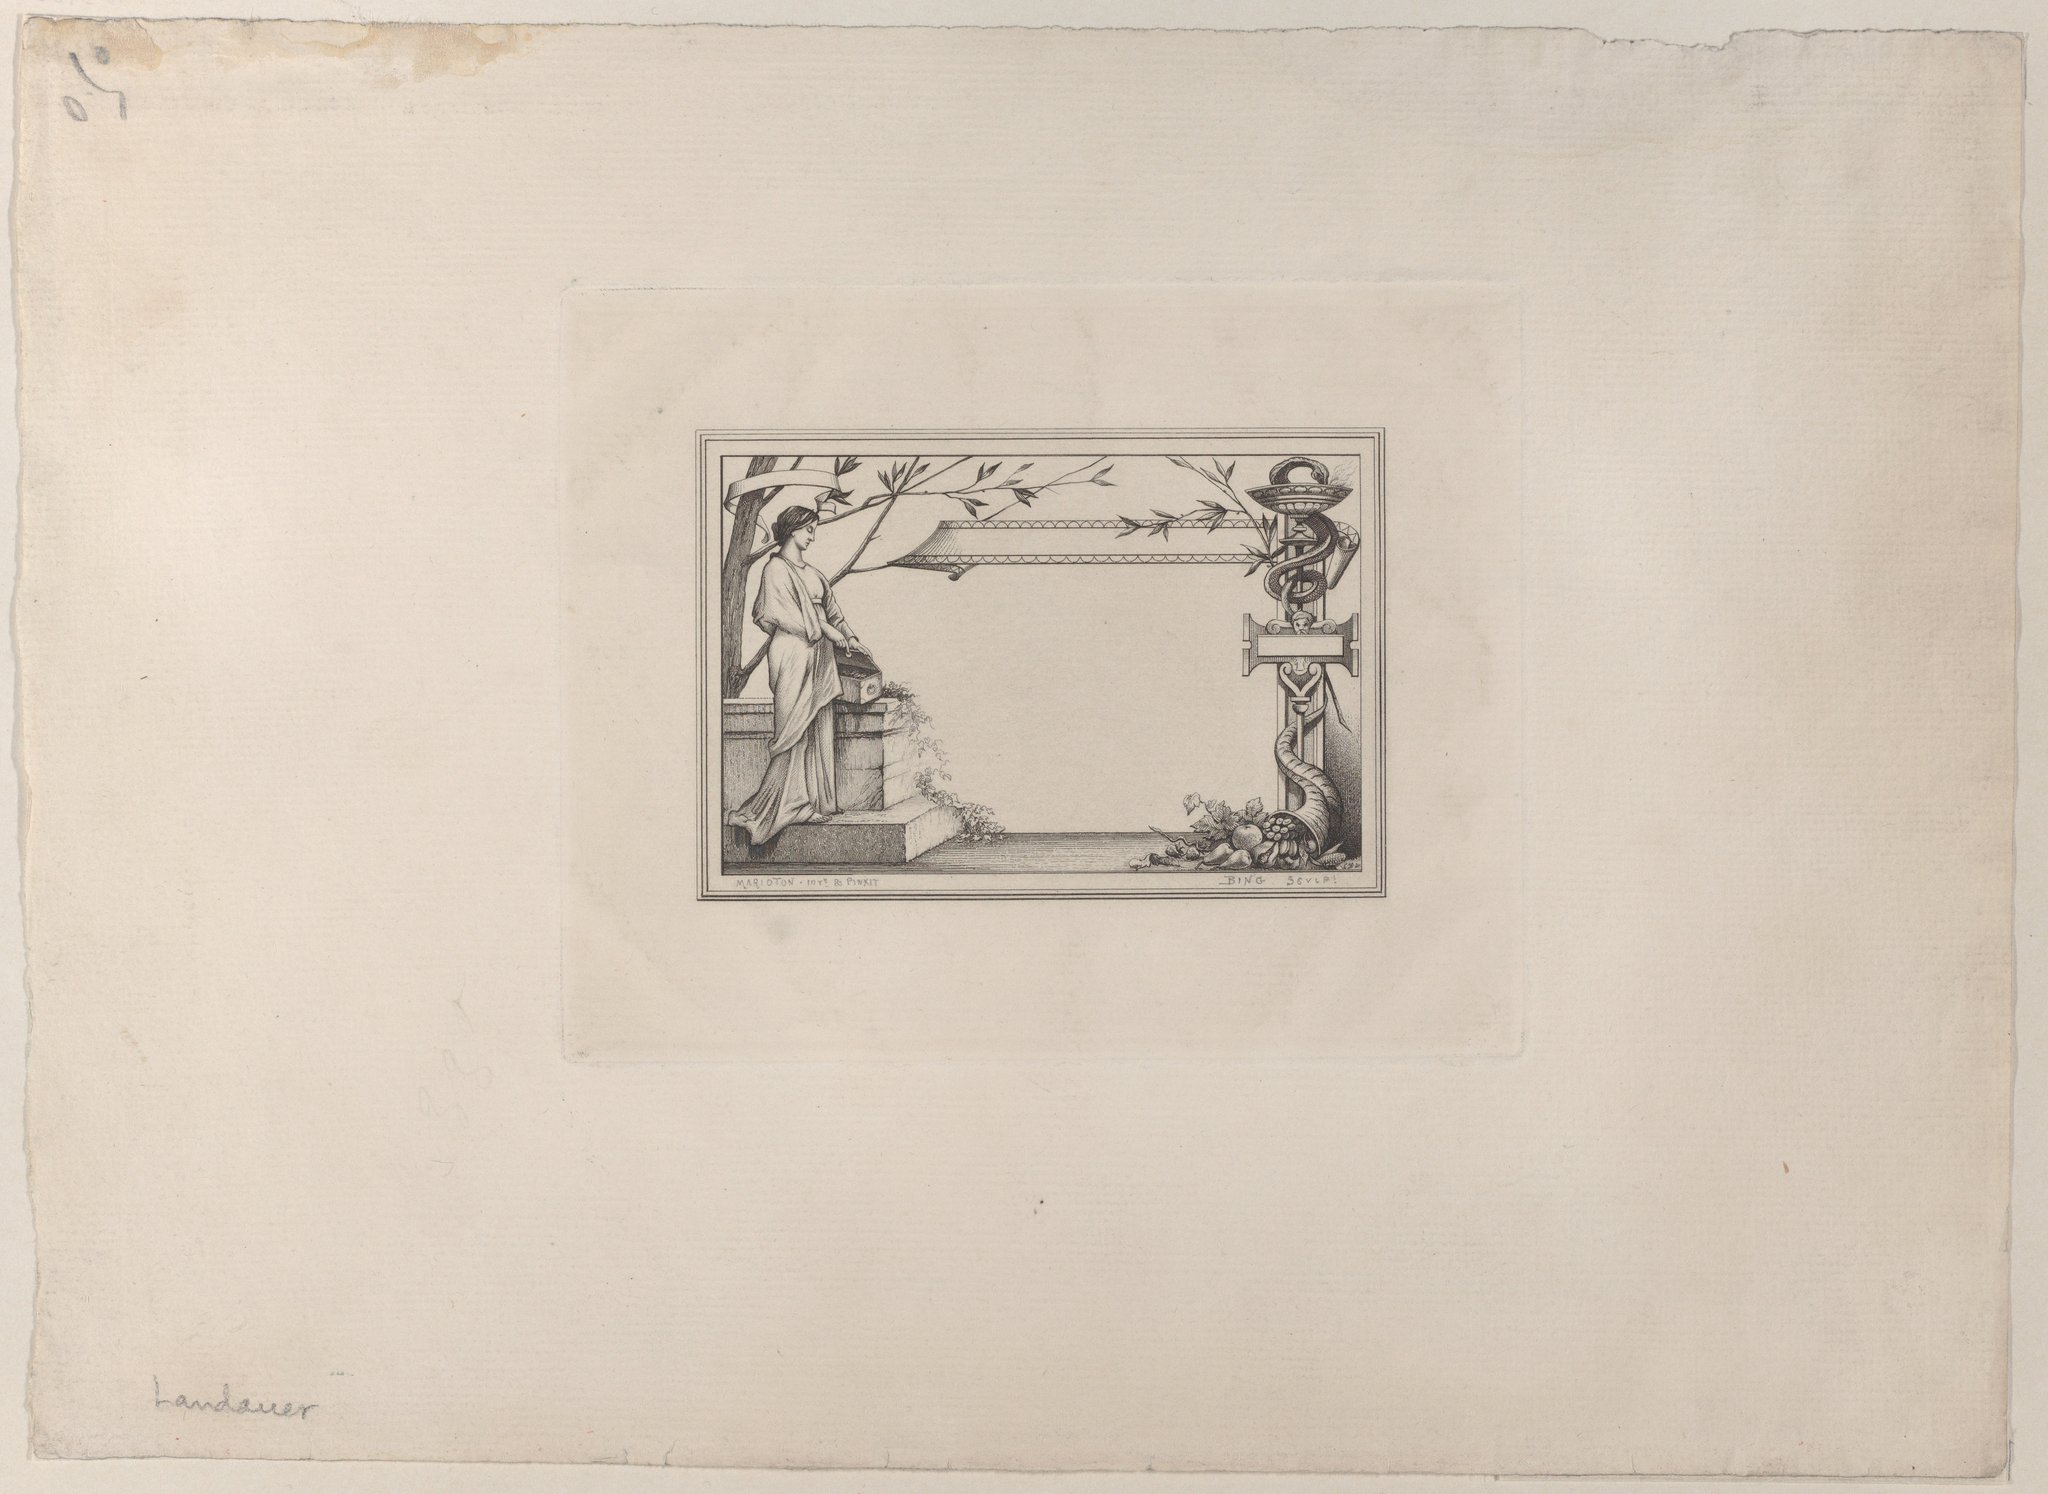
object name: print, trade card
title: Trade Card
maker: anonymous, british, 19th century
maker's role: artist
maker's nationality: british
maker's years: 1800-1900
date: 1801-1900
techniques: engraving